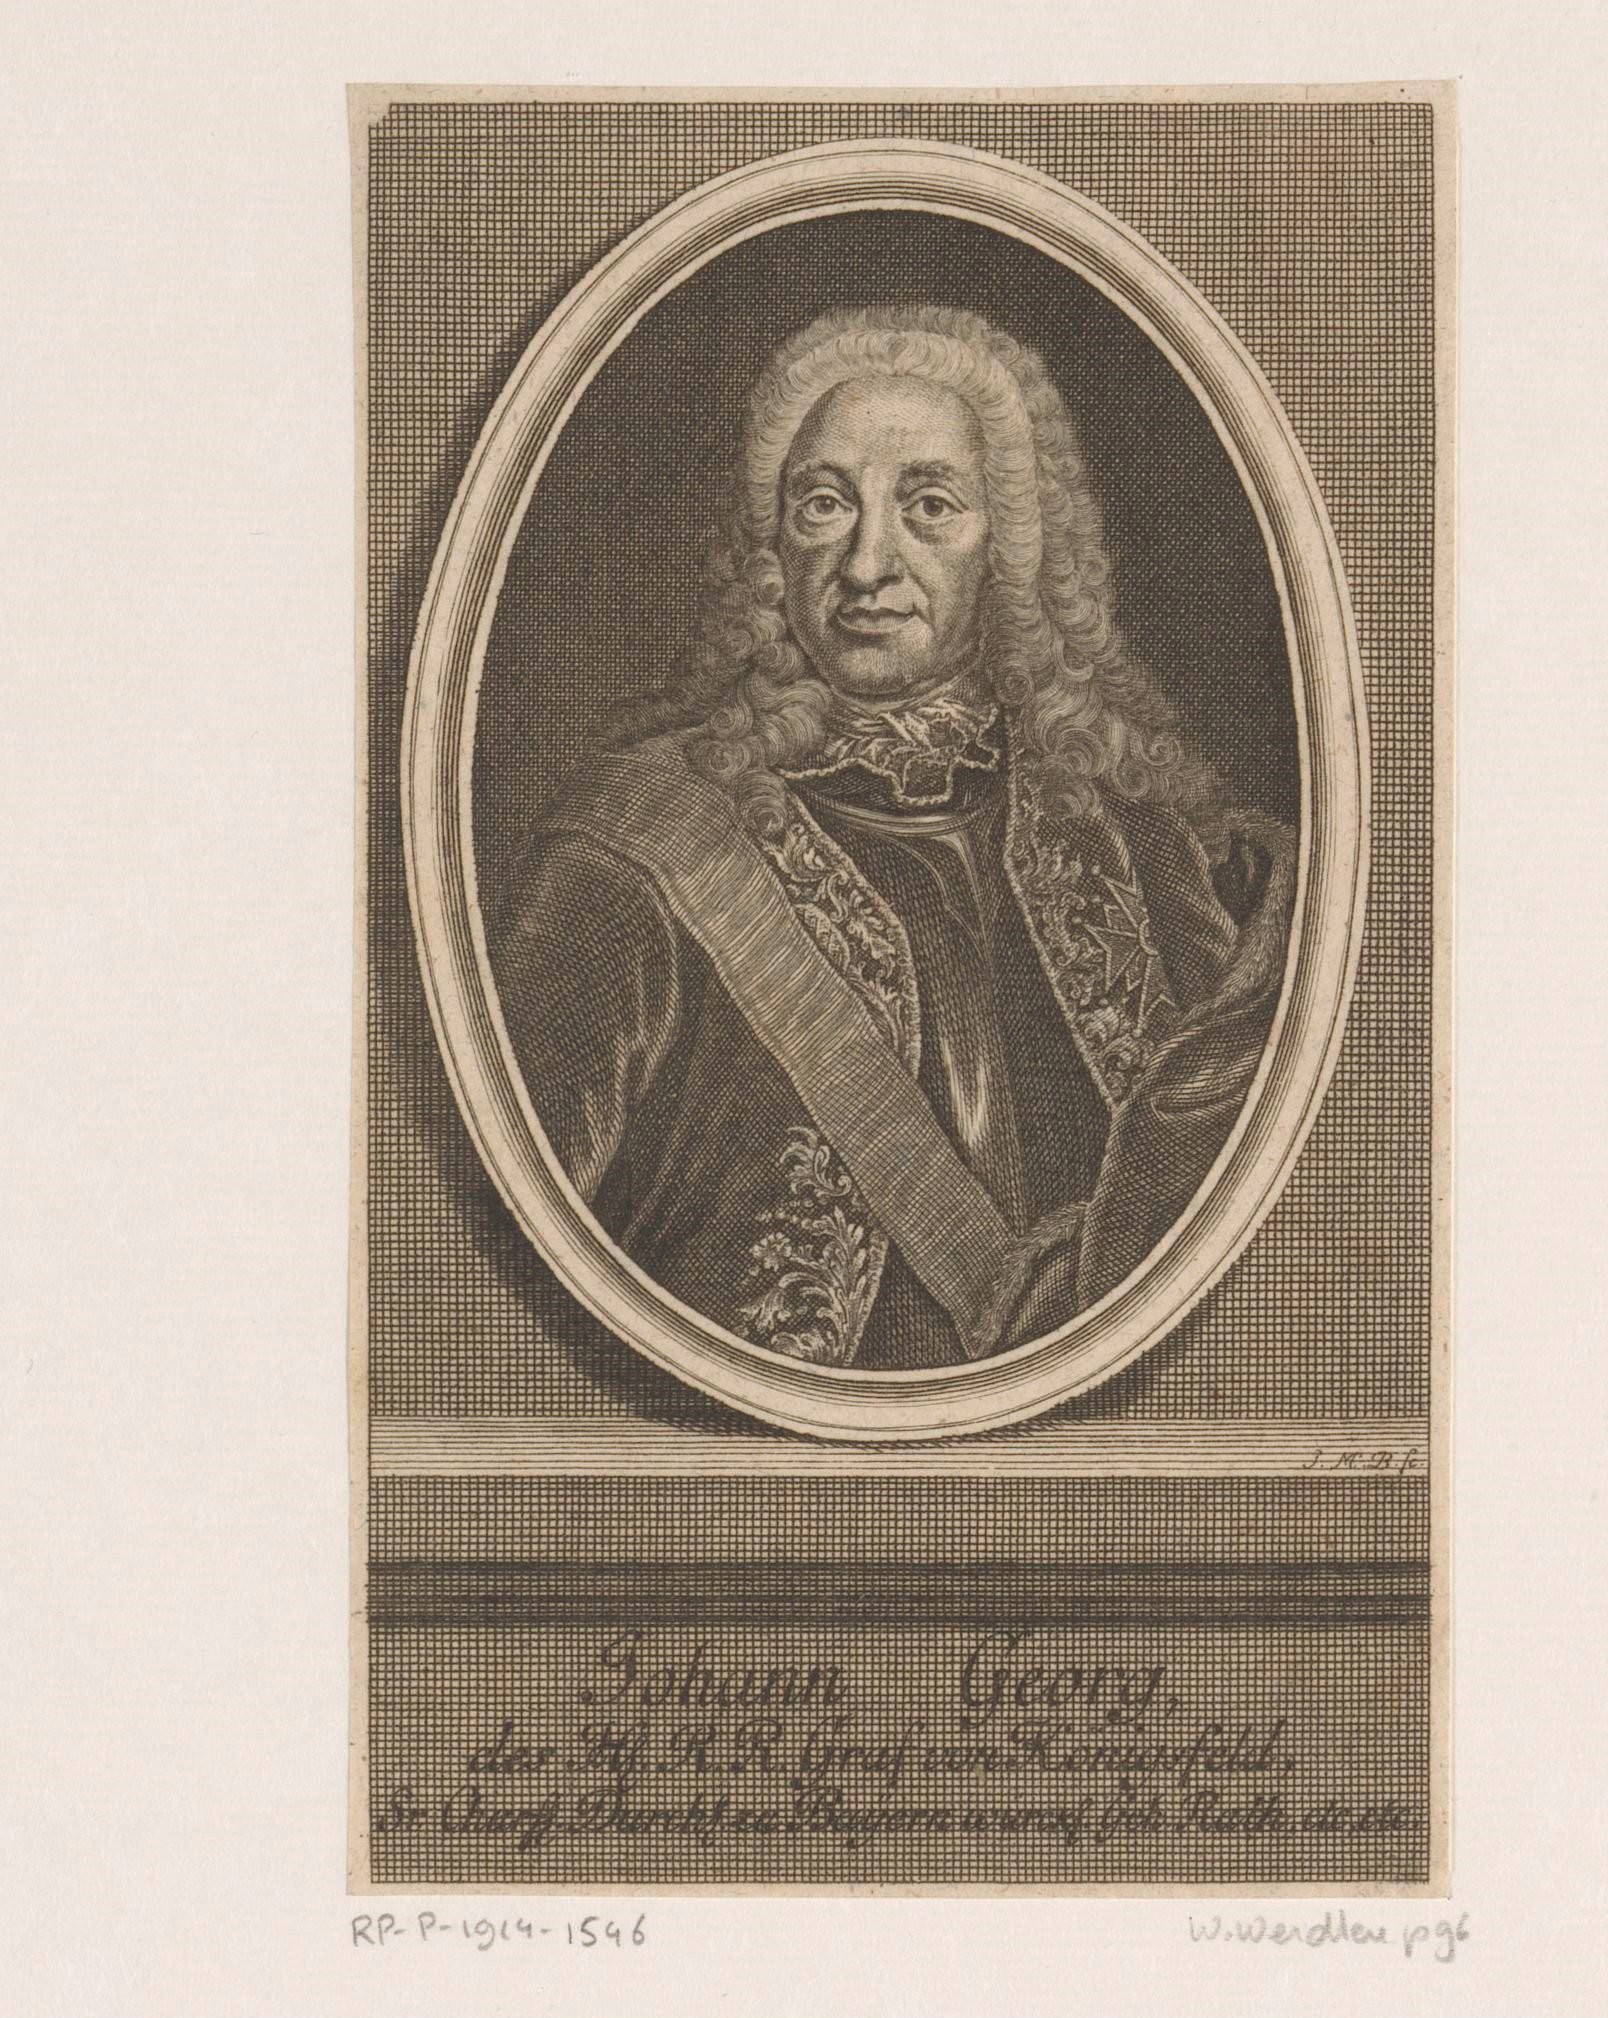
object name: print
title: Portret van Johann Georg Graf von Königsfeld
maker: johann martin bernigeroth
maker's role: print maker, publisher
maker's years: 1713-1767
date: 1738-1767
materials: paper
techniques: engraving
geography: leipzig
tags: historical persons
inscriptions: collector's mark: Lugt 2228